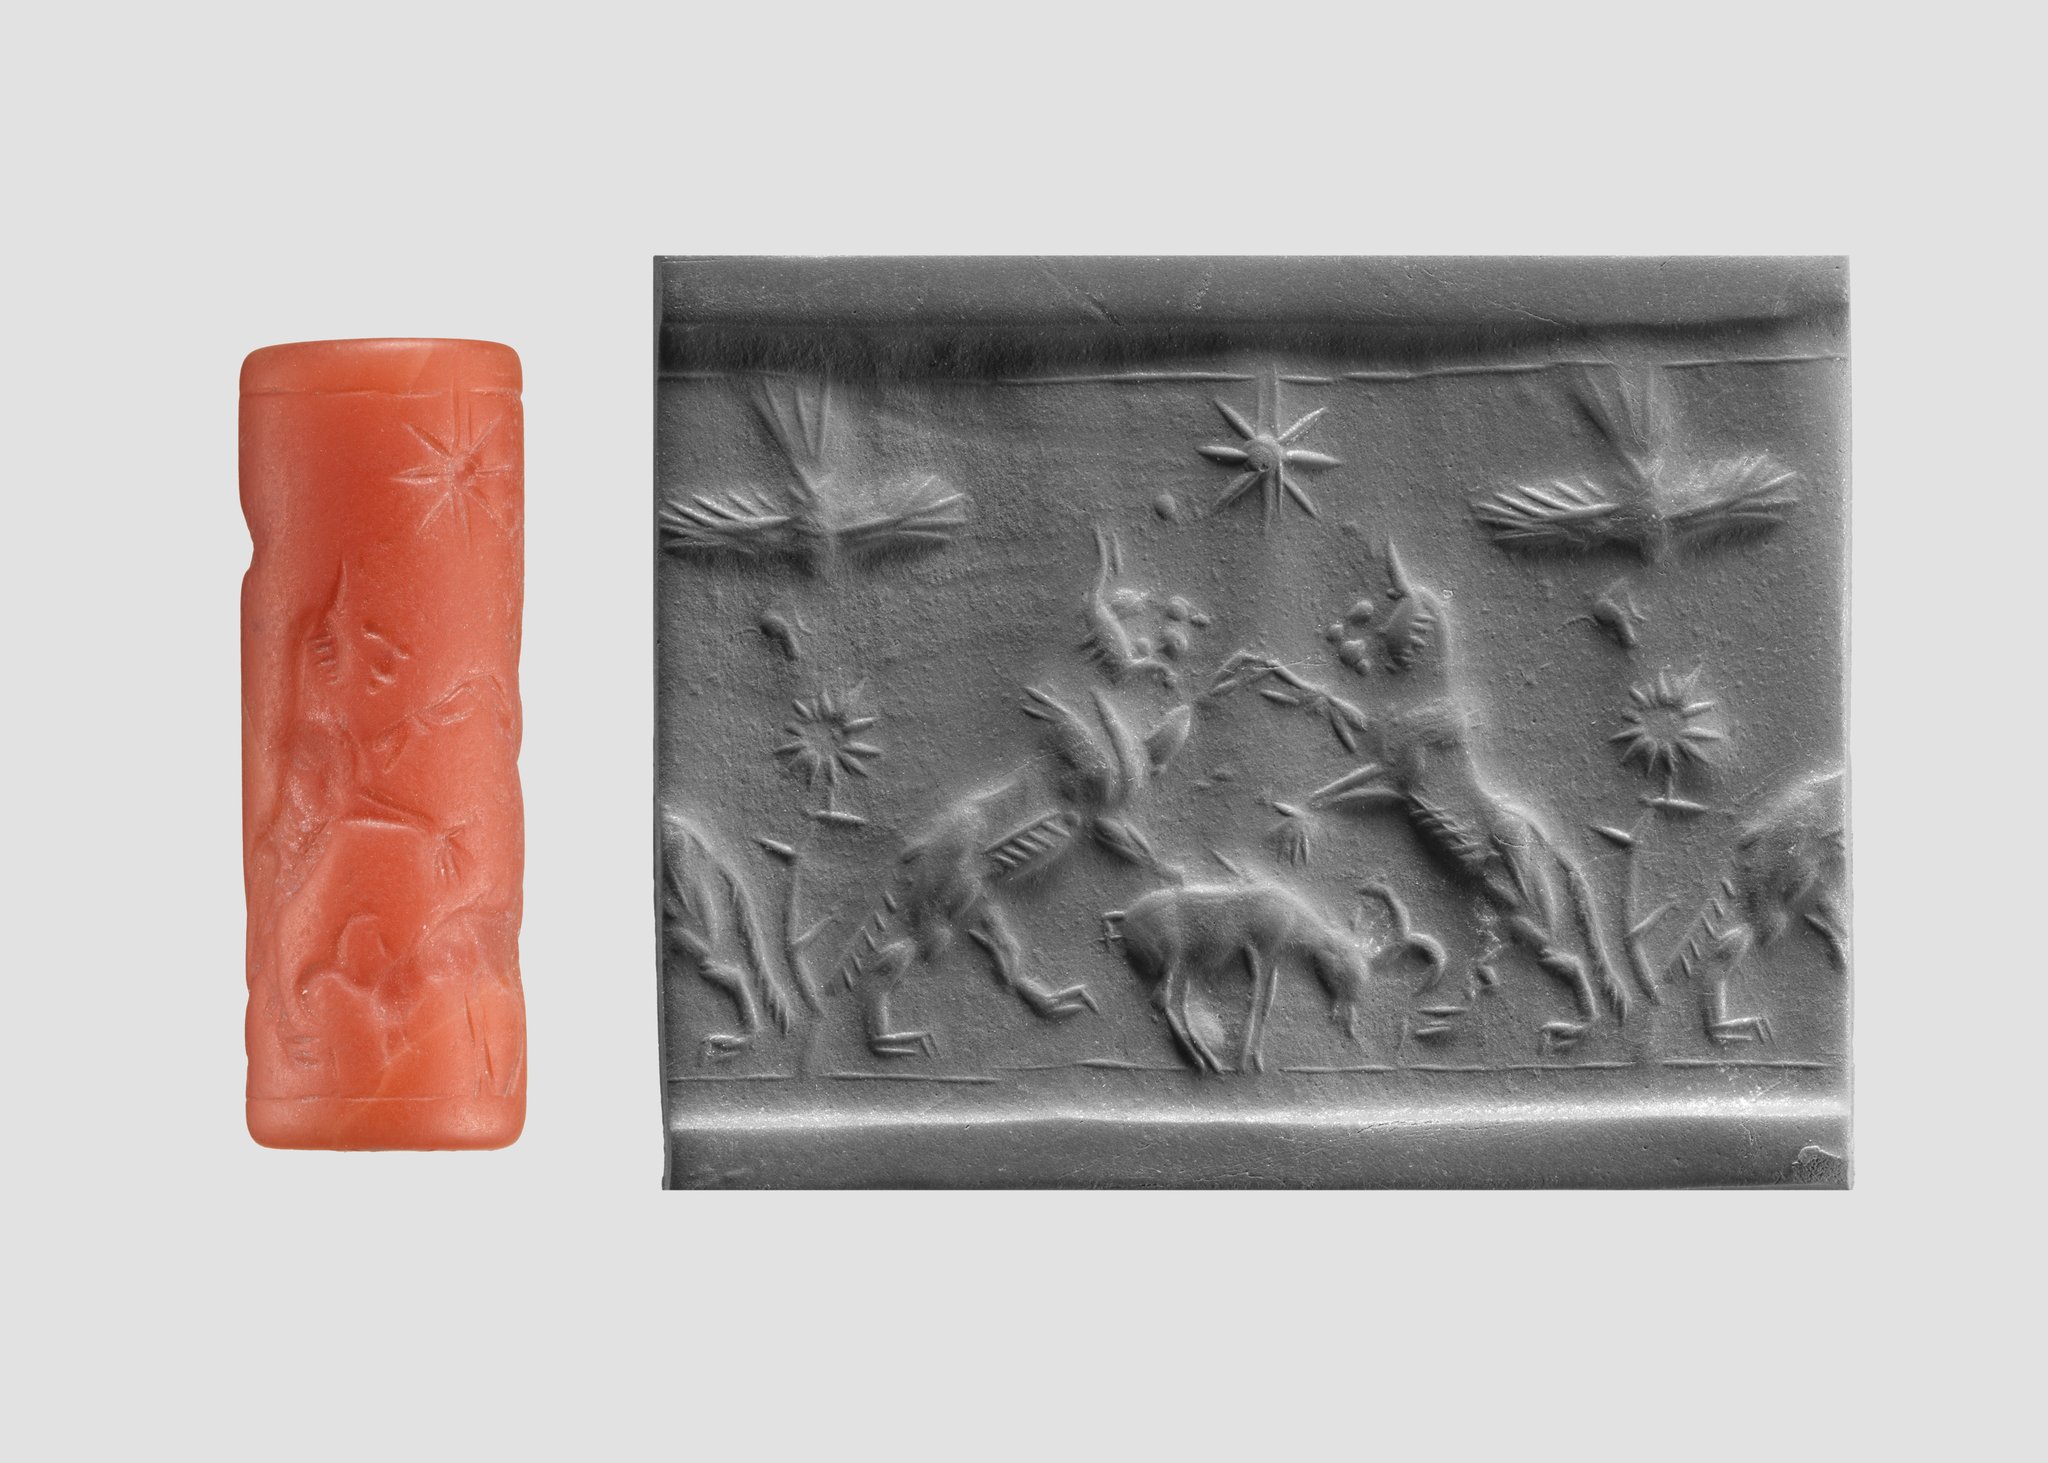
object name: cylinder seal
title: Cylinder seal and modern impression: rampant lions over grazing ram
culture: assyrian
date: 1300-1201 BCE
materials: gemstone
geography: mesopotamia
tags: lions,rams